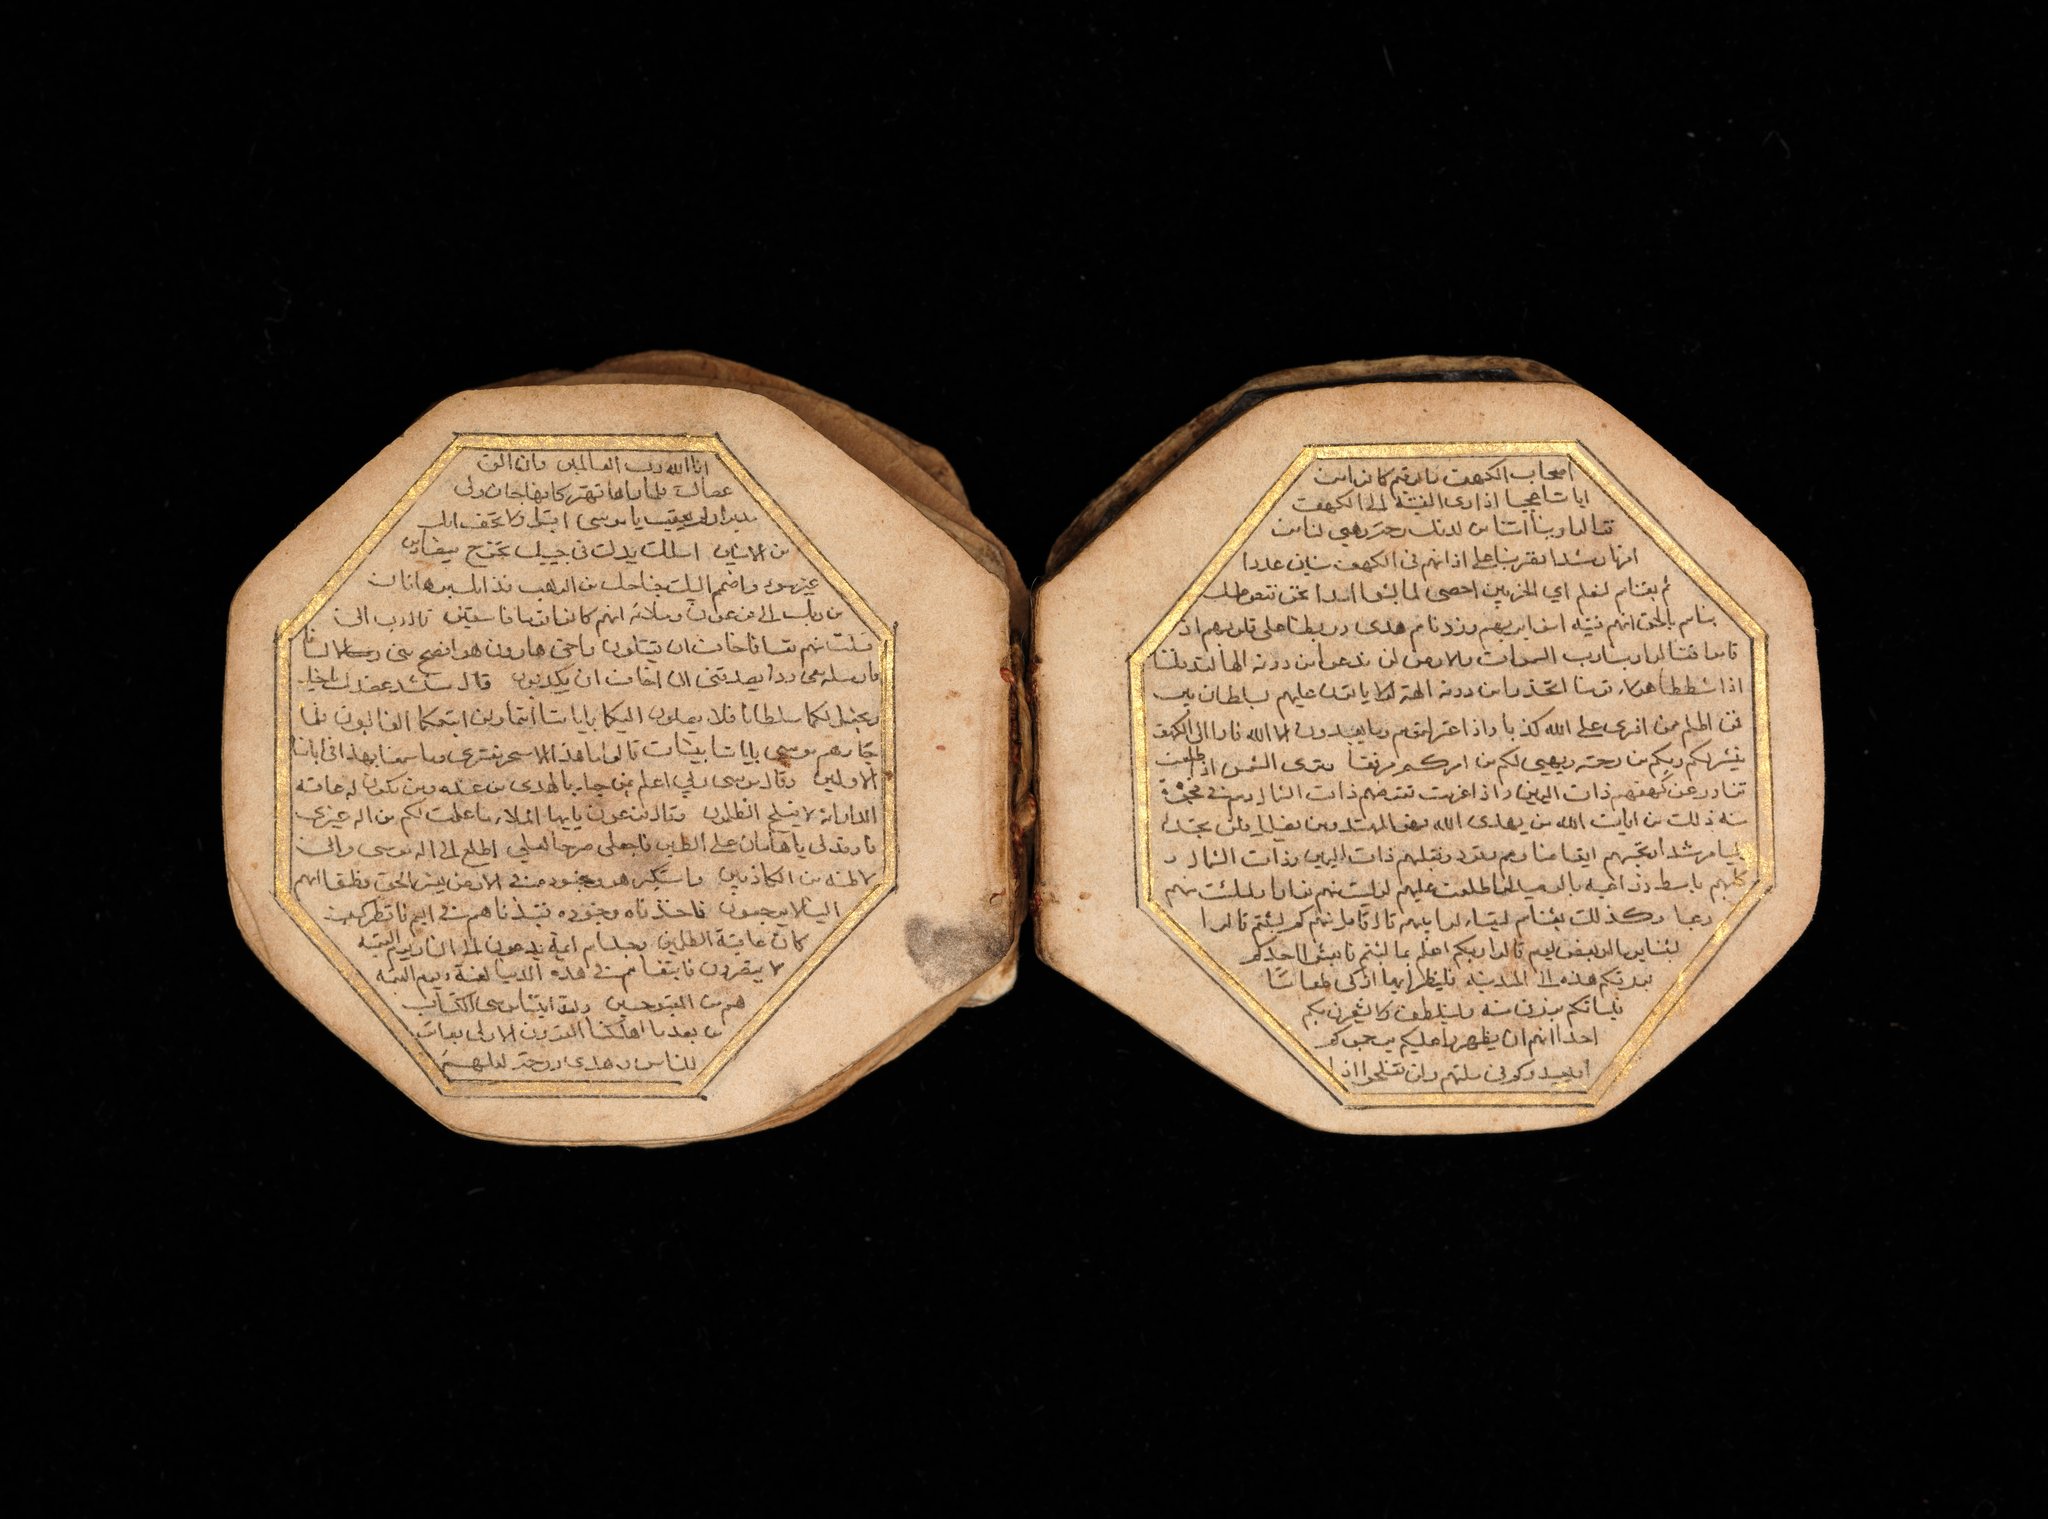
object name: non illustrated manuscript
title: Portable Qur’an Manuscript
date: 1601-1700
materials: gold, ink, leather, paper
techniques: bookbinding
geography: iran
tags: arabic,qur'an